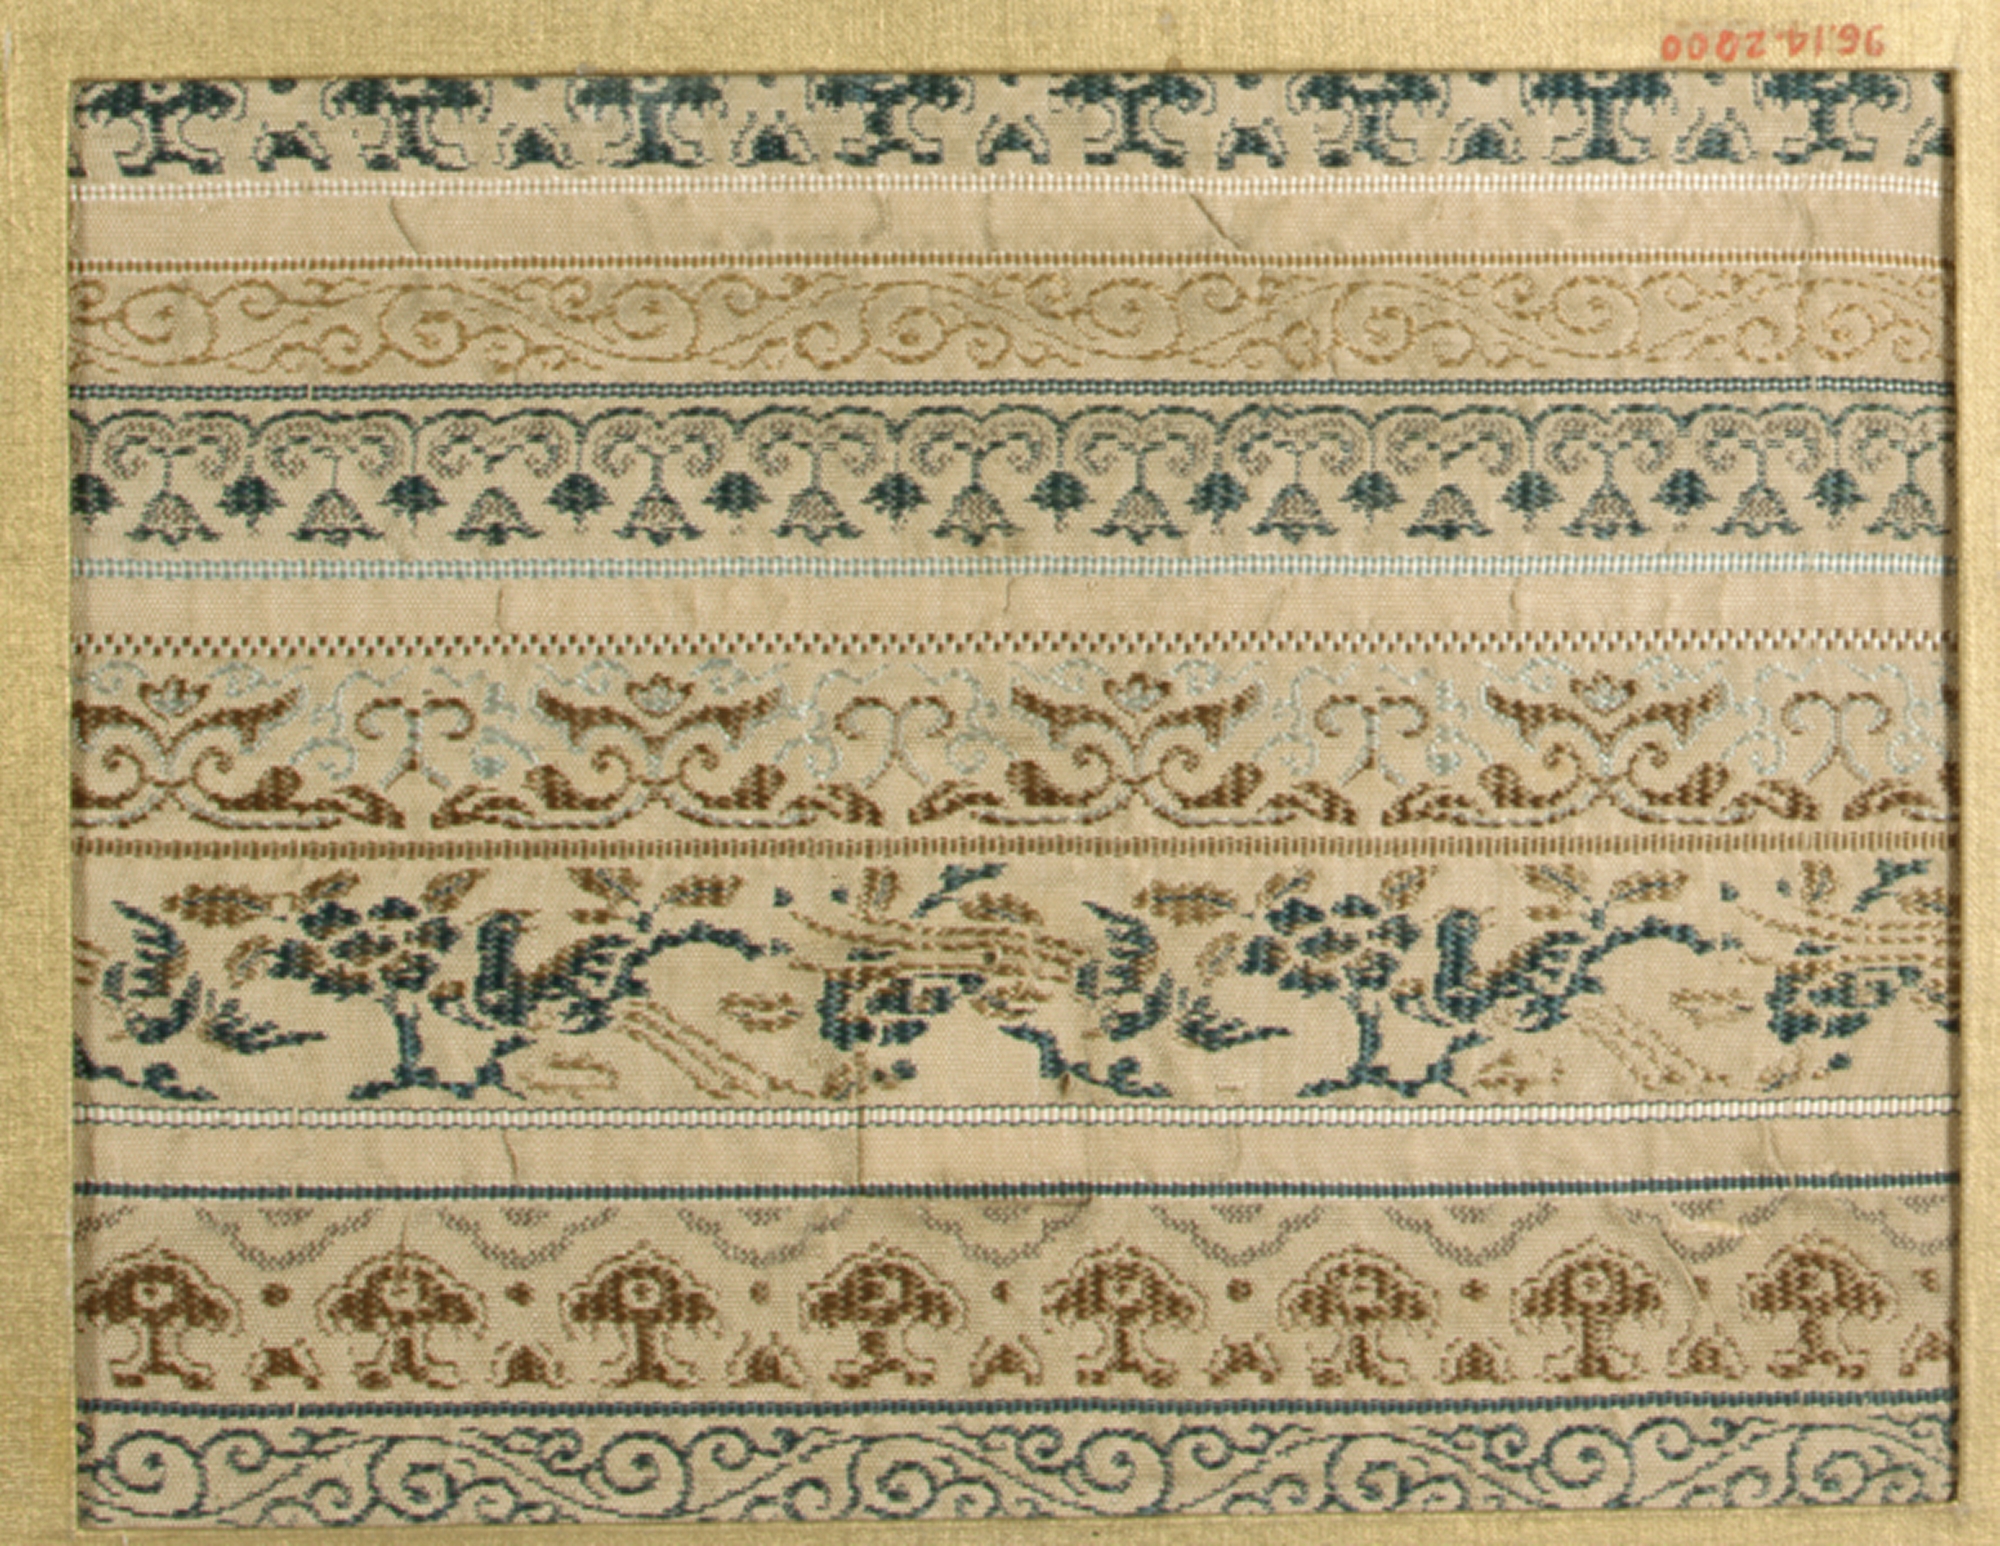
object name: piece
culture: japanese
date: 1701-1900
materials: silk